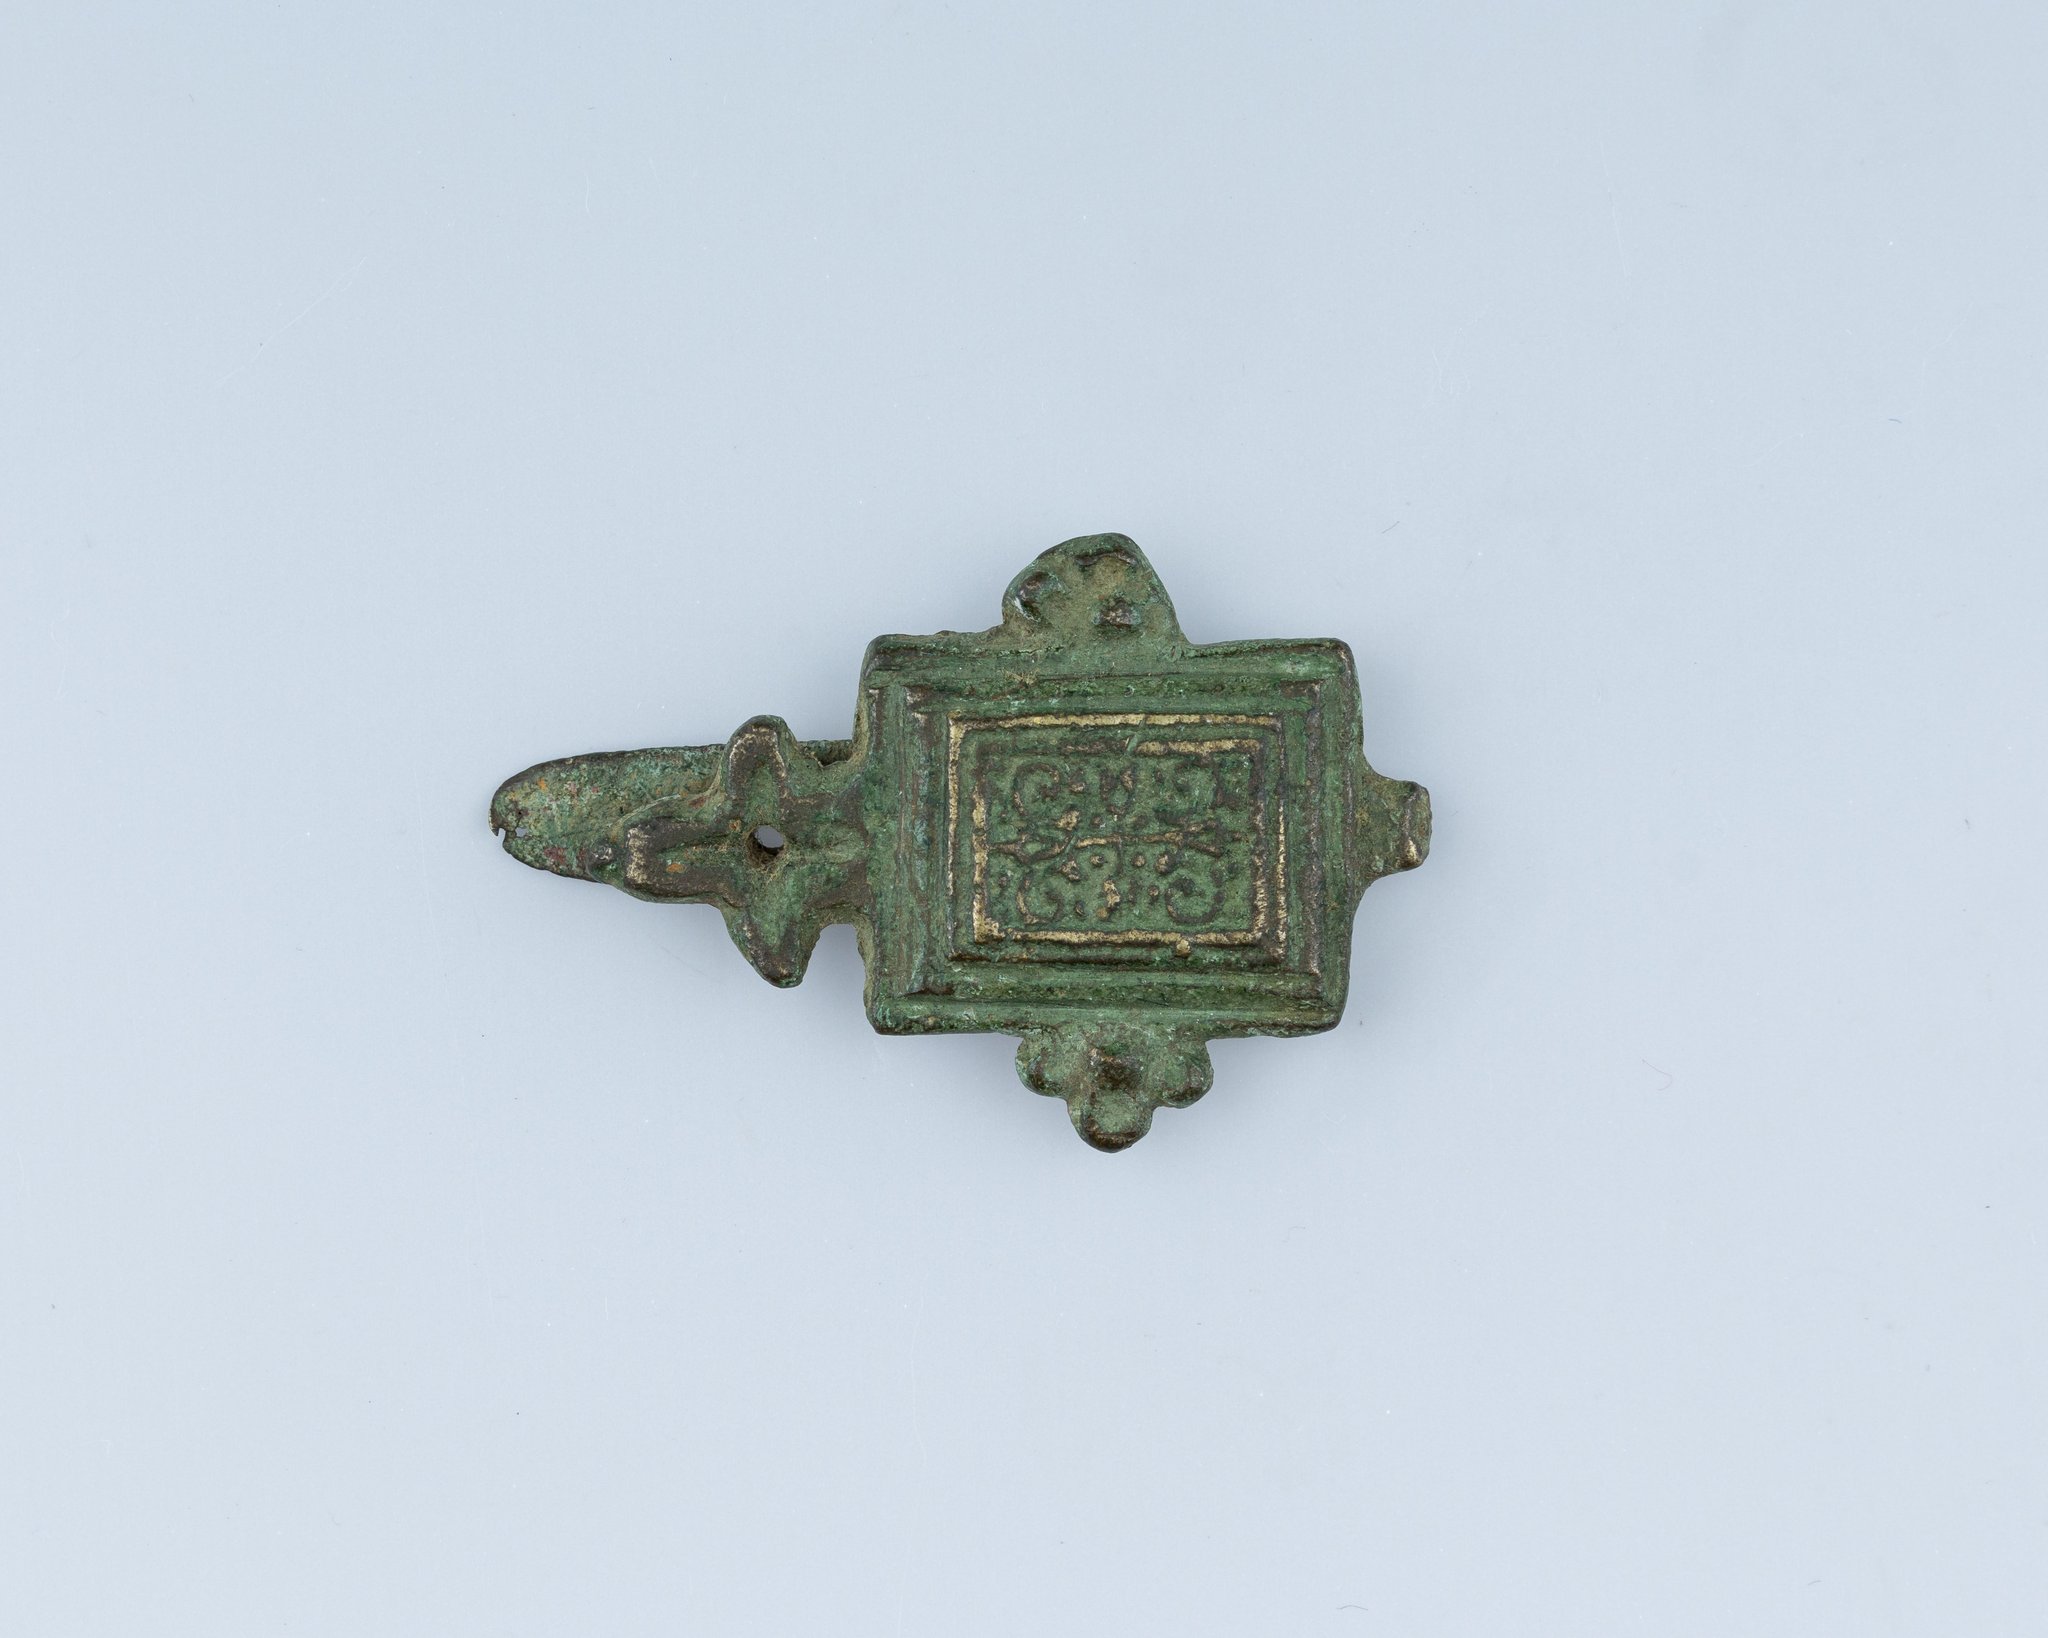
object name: pendant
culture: french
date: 1601-1700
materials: bronze, patina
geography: france